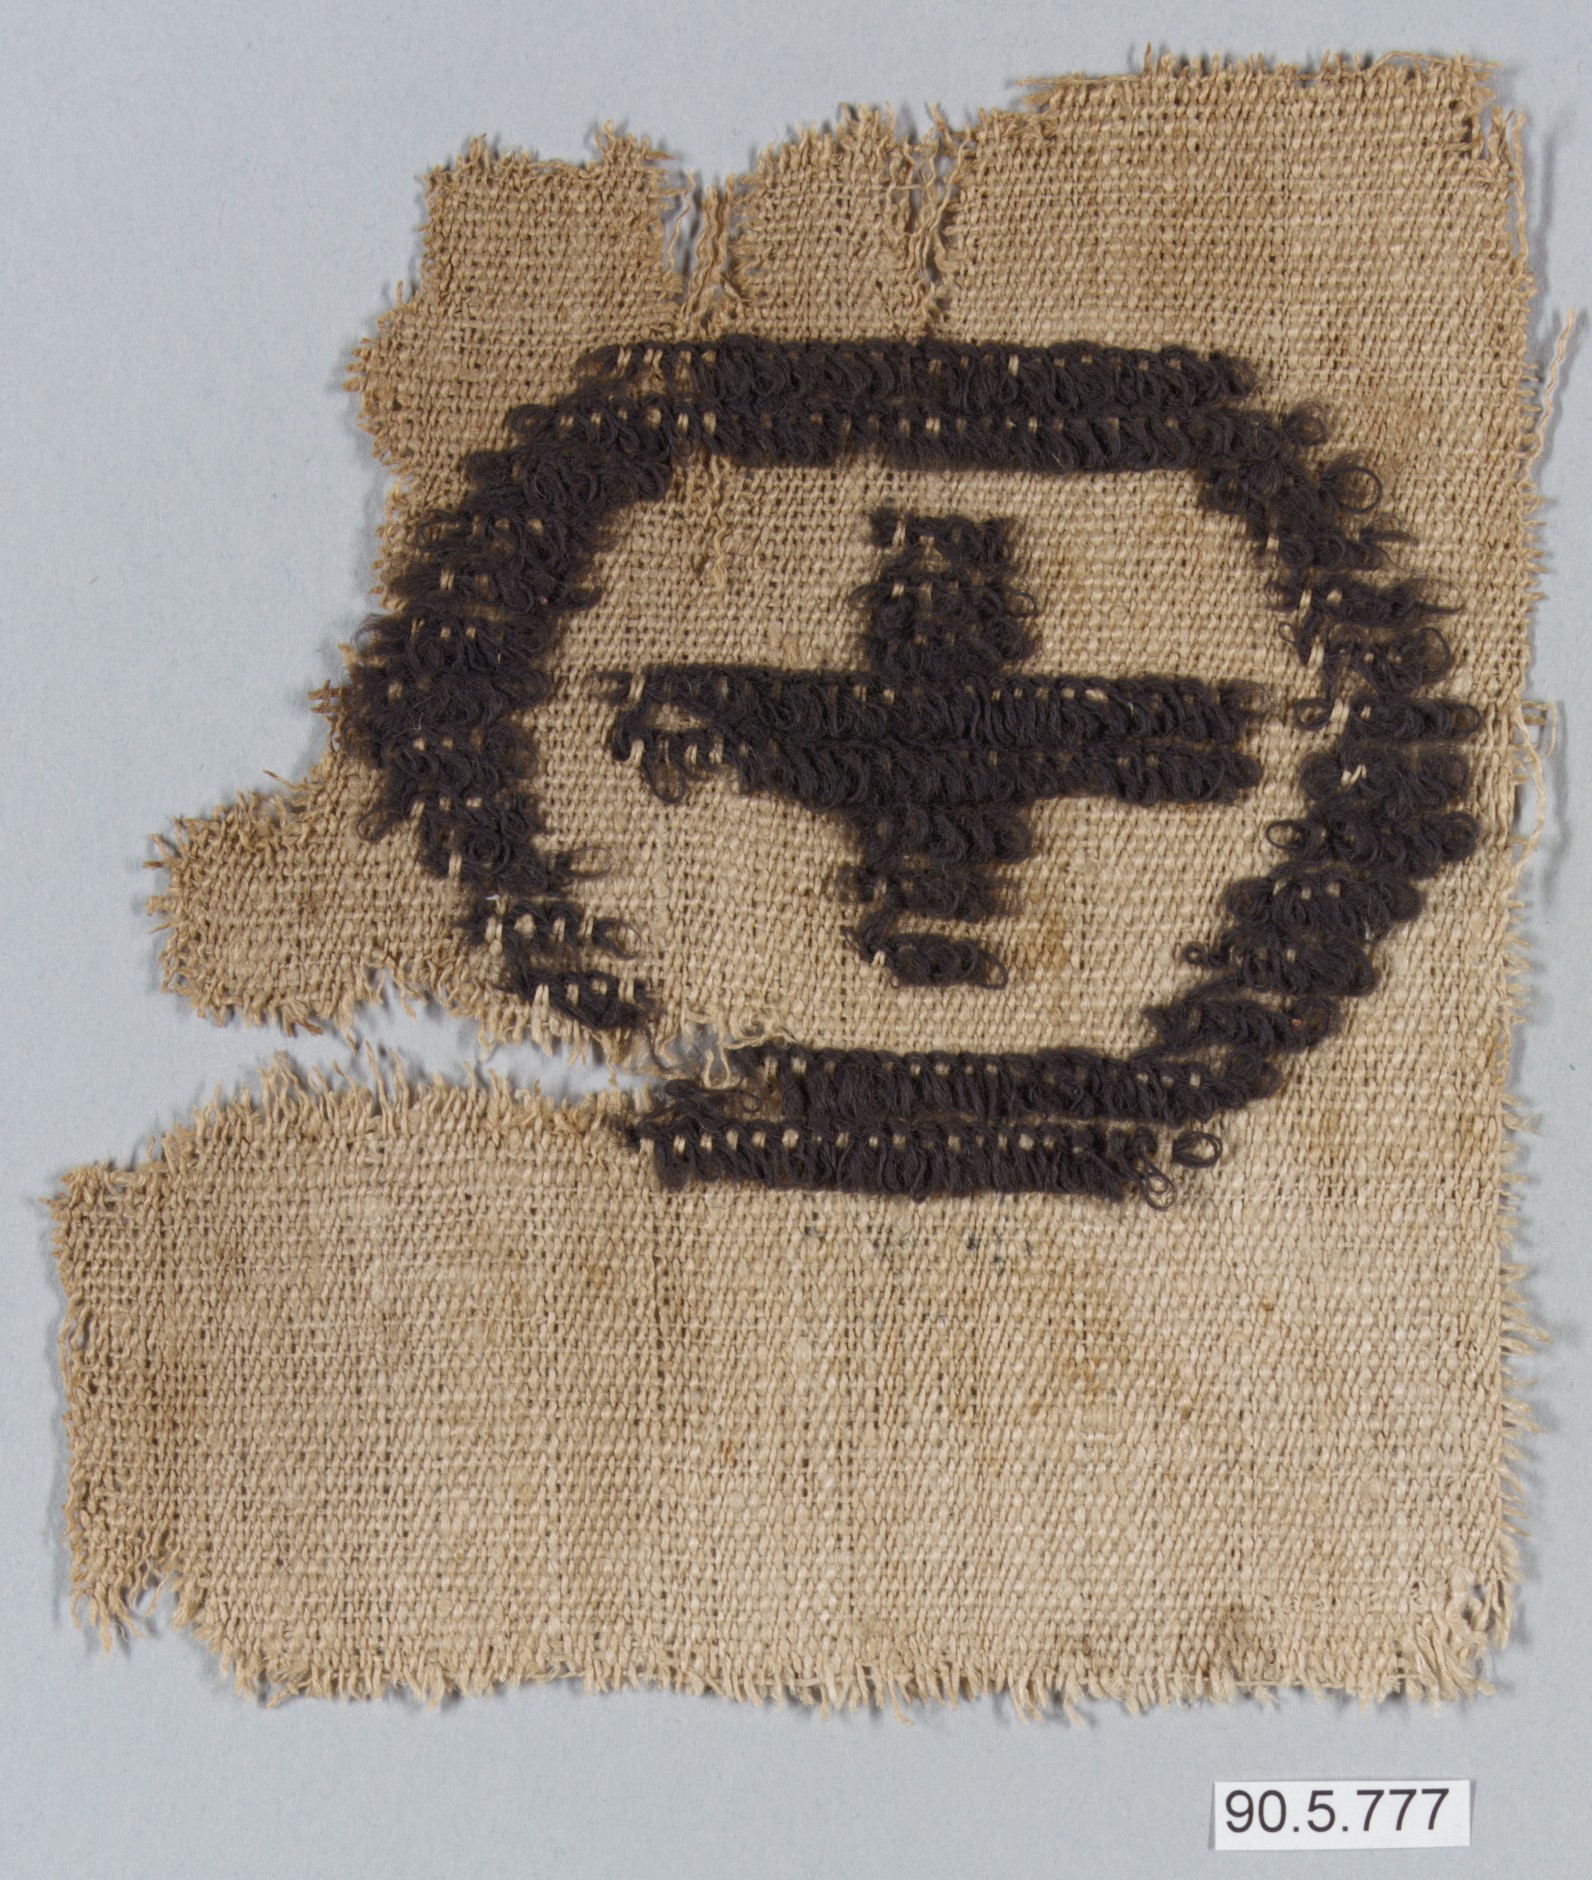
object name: textile fragment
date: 301-500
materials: linen, wool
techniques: weave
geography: egypt